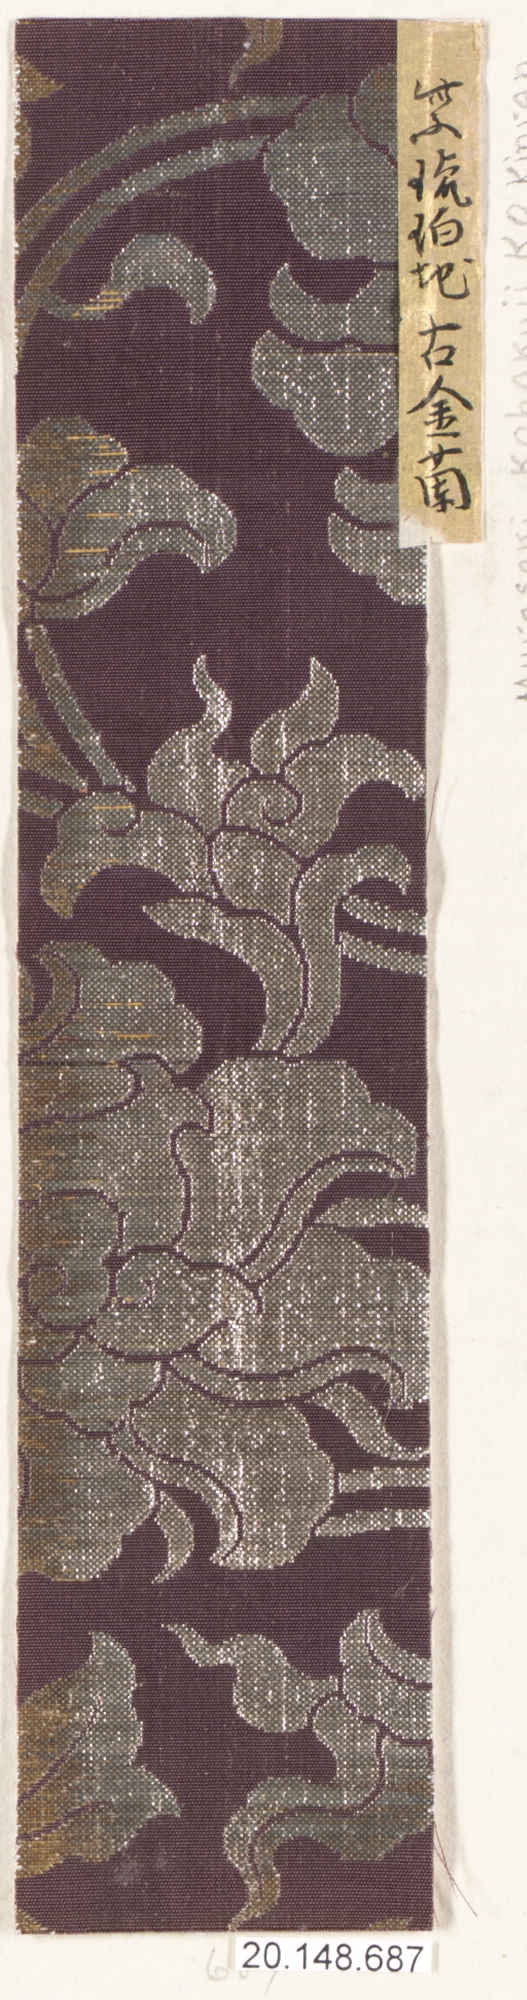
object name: piece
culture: japanese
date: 1601-1700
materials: silk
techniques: compound weave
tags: flowers